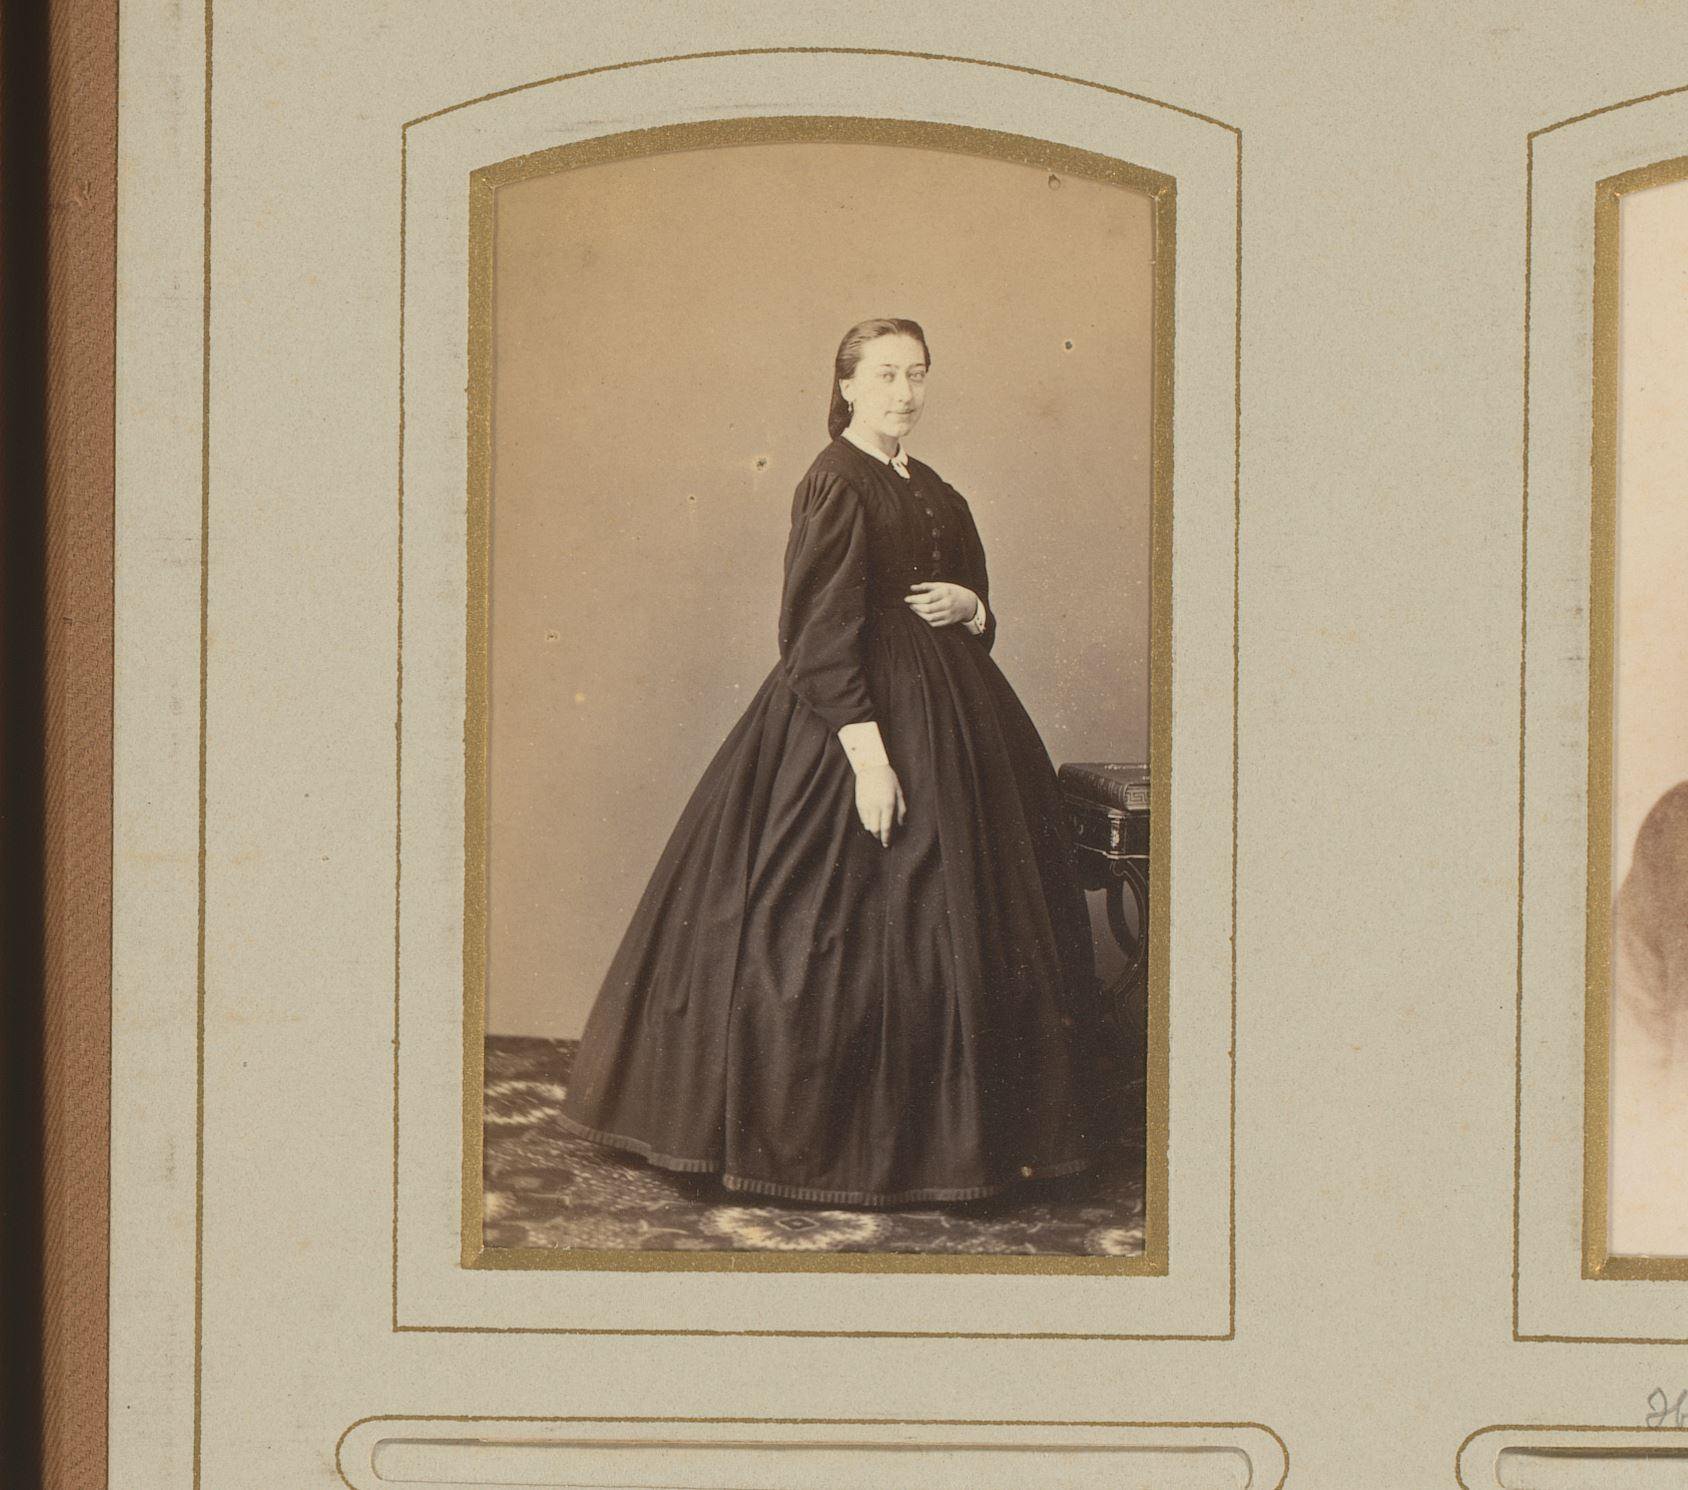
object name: photograph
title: Portret van een staande vrouw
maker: césar mitkiewicz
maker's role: fotograaf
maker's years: 1836-1871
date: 1860-1900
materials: cardboard, photographic support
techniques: albumen print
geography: brussels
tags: historical persons - bb - woman, standing figure - aa - female human figure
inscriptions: inscription: ‘CESAR MITKIEWICZ/ PHOTOGRAPHE/ 9, Rue Neuve, 9/ BRUXELLES’